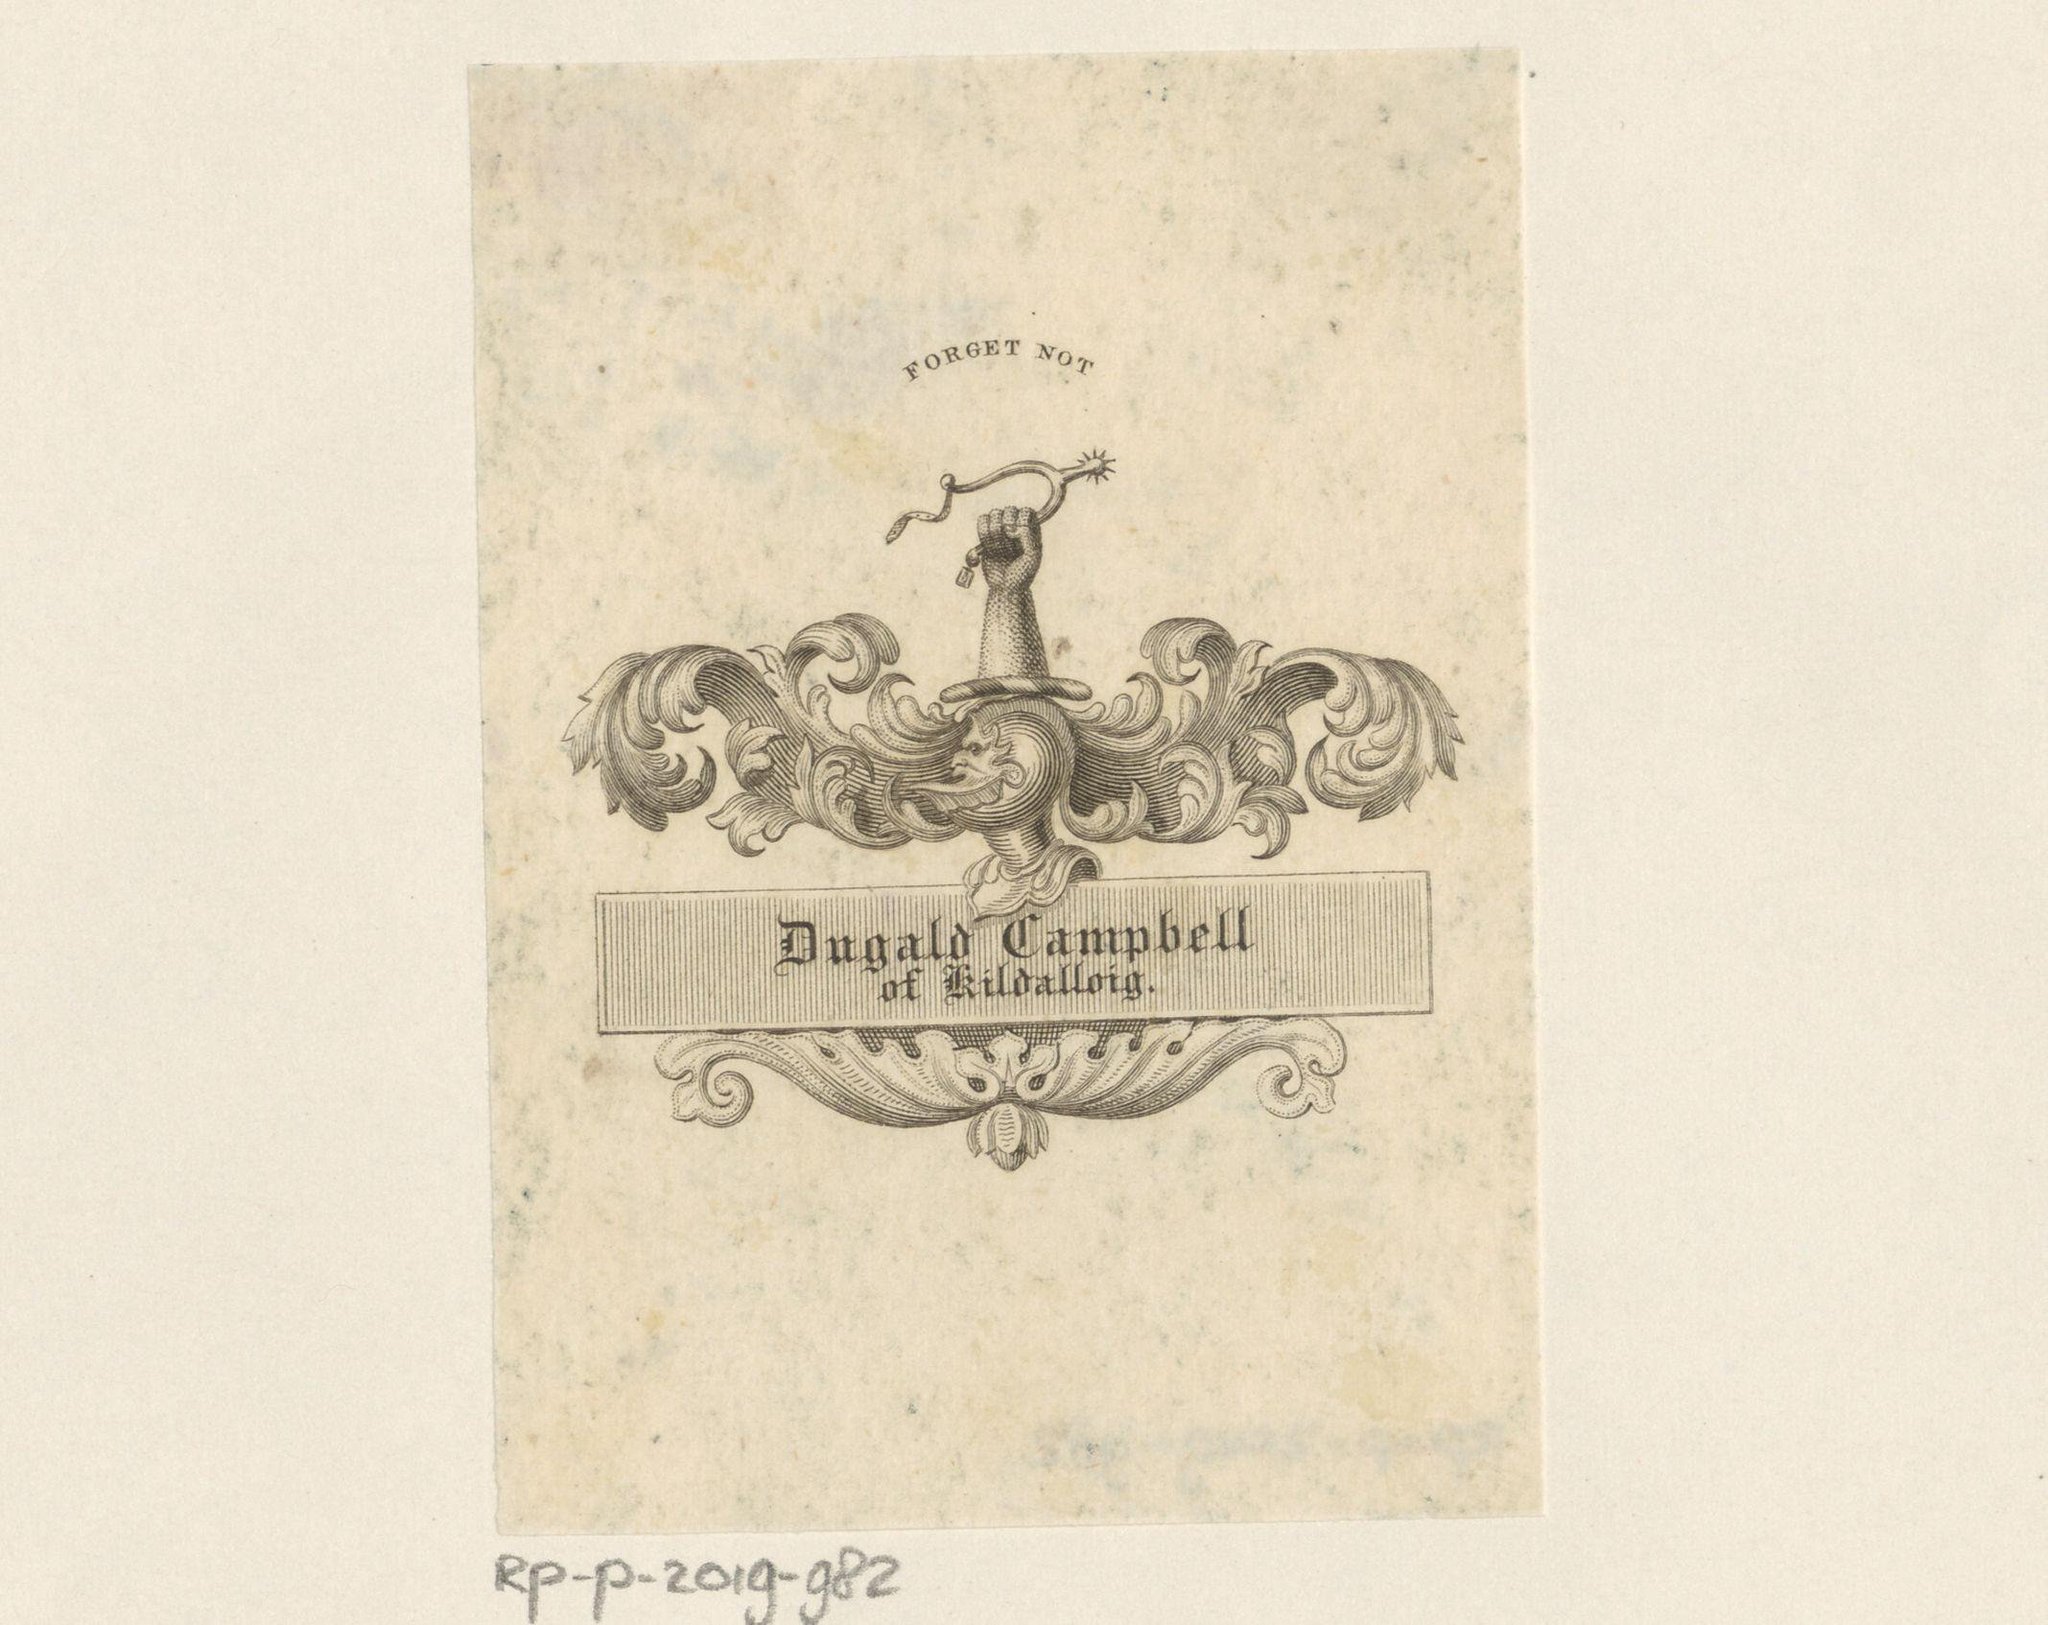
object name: bookplate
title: Forget not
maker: Anonymous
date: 1790-1834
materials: paper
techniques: etching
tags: armorial bearing, heraldry